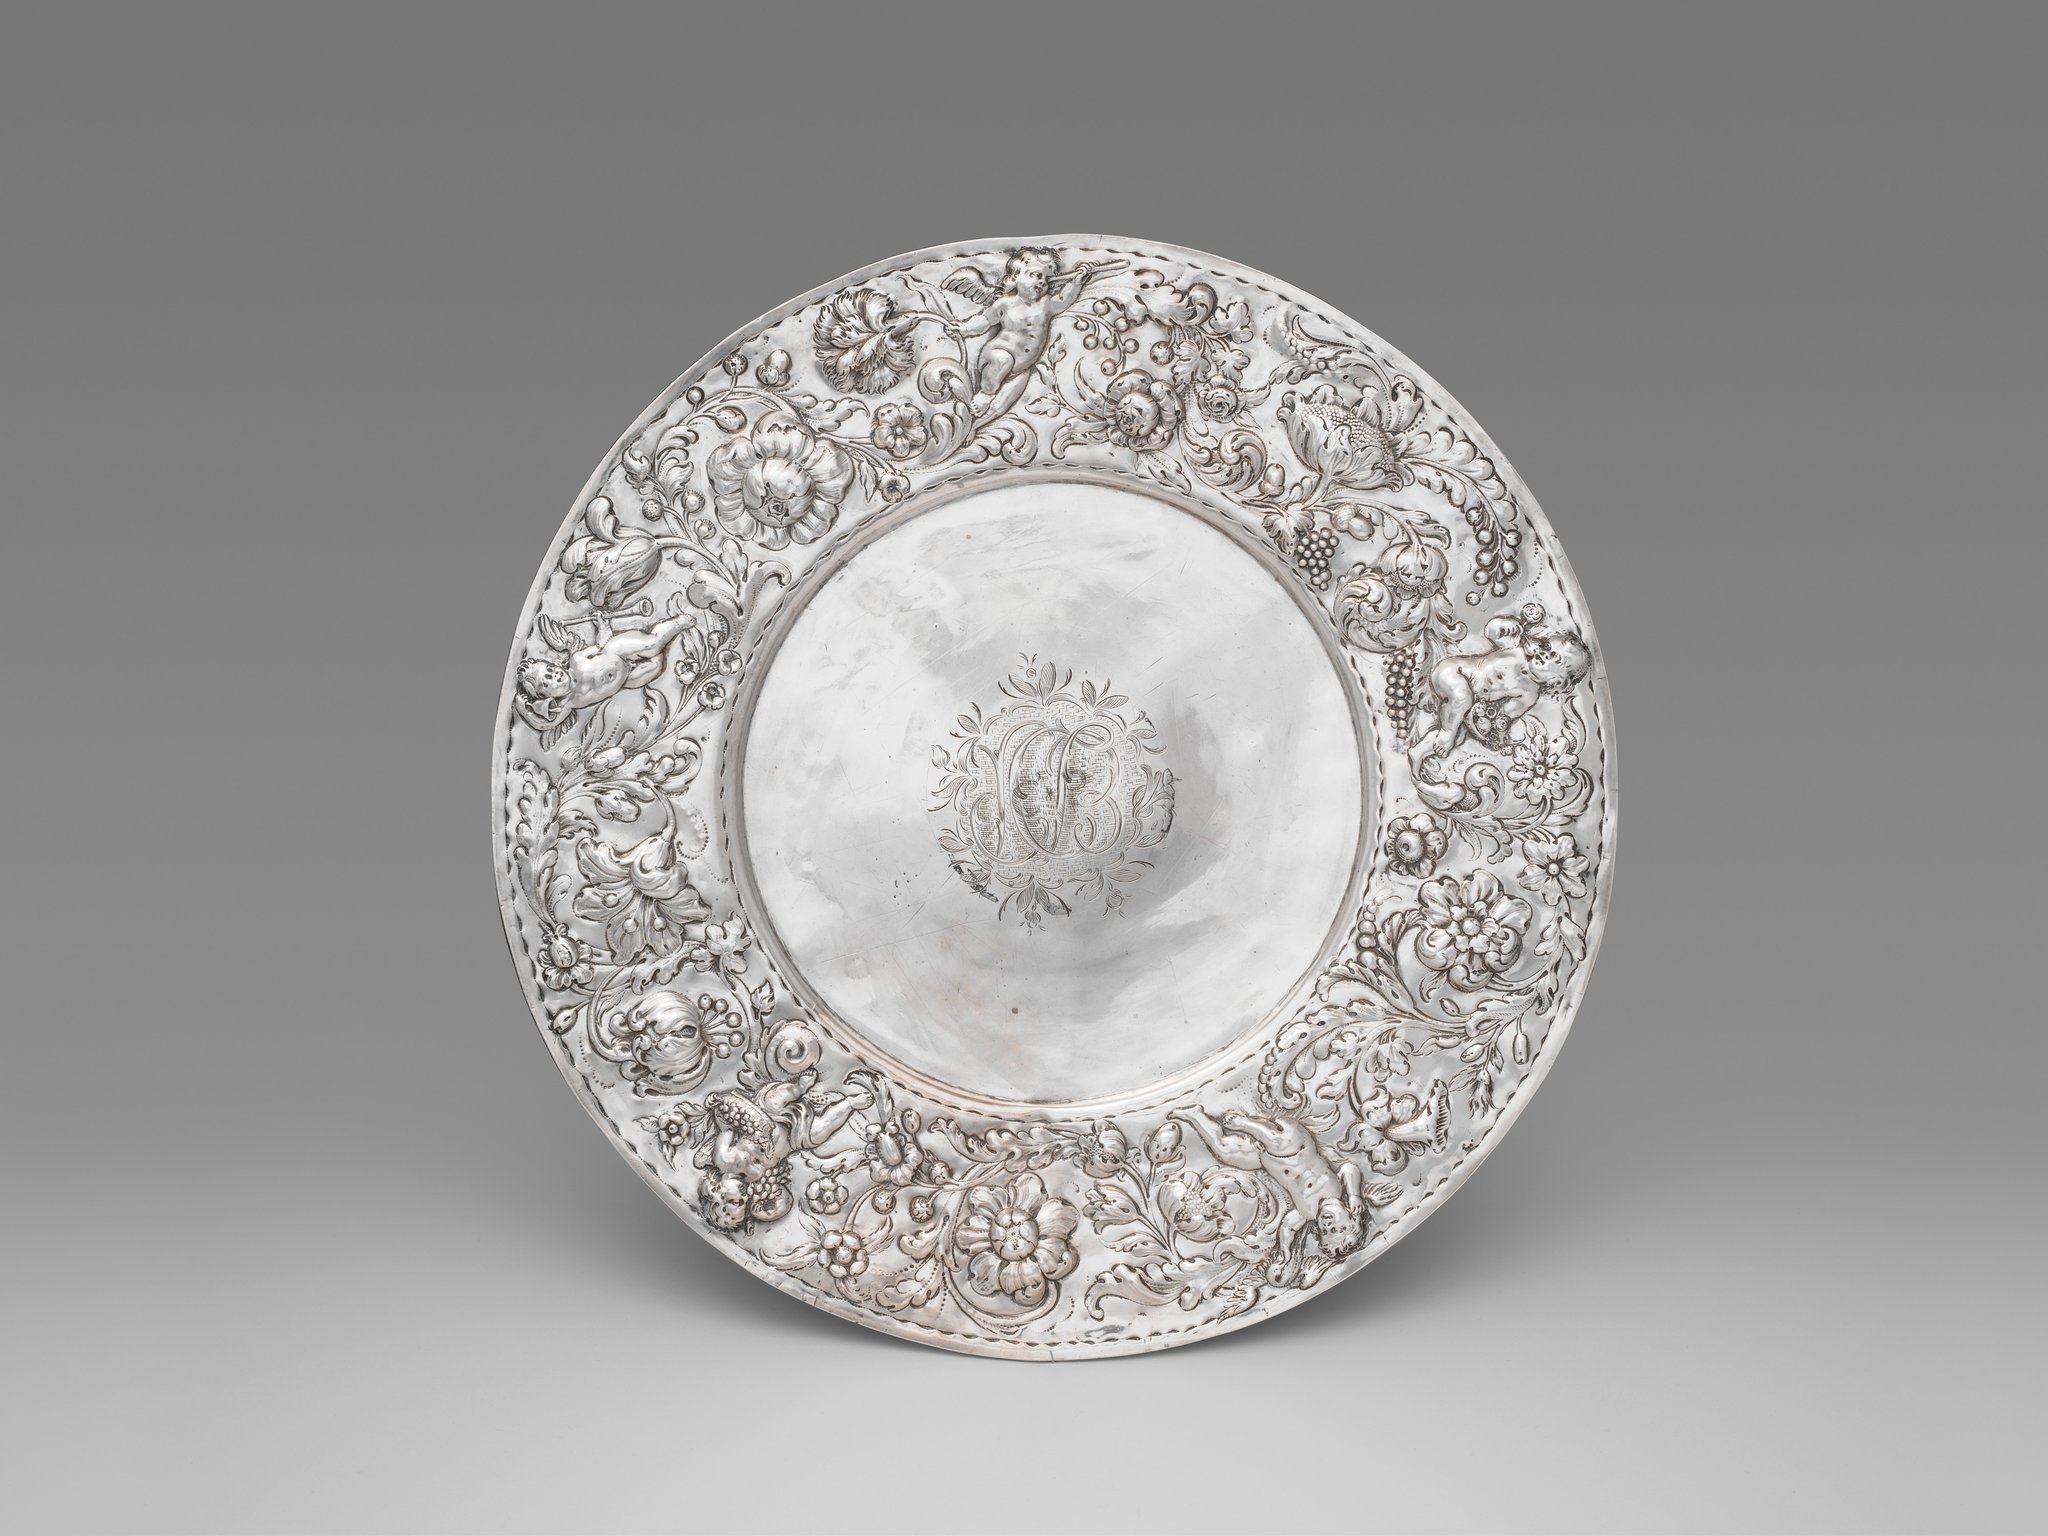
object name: dish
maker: sigismund zschammer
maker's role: maker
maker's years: 1630-1698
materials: silver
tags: grapes,flowers